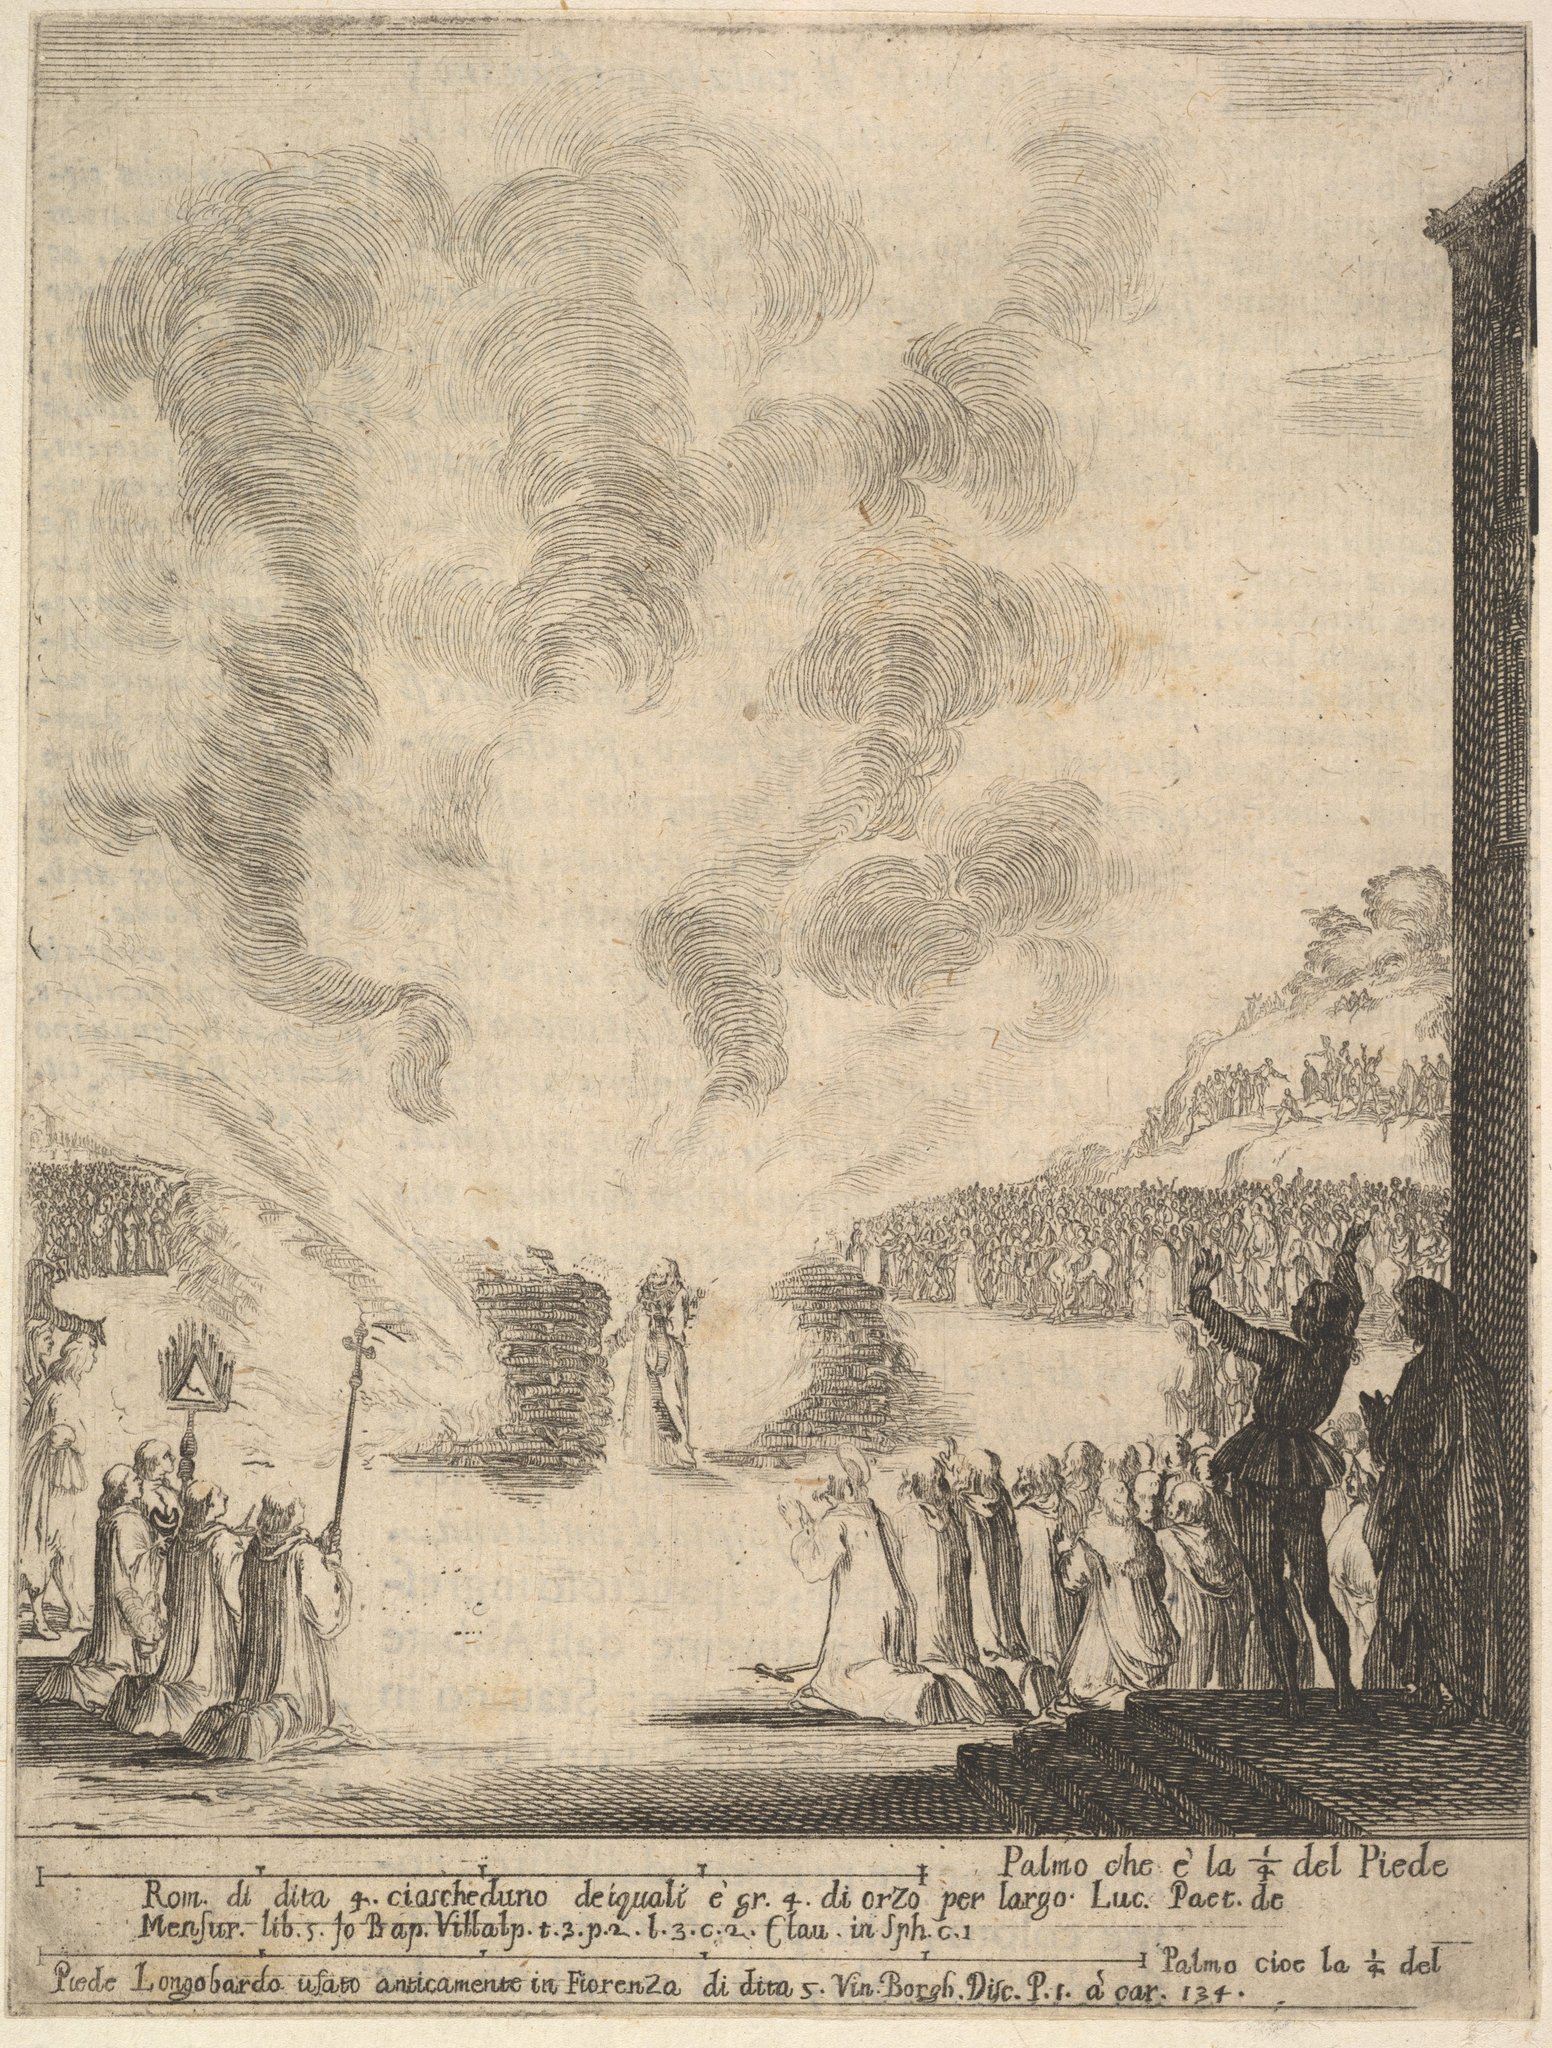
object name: print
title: The test of fire, the monk Peter, the disciple Saint John Gualbert, passing through the flames from two pyres unharmed, from "Frontispiece and four scenes from the life of Saint John Gualbert" (Frontispice et quatre vignettes pour une vie de Saint Jean Gualbert)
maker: stefano della bella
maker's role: artist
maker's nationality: italian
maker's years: 1610-1664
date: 1640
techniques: etching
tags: spectators,fire,saints